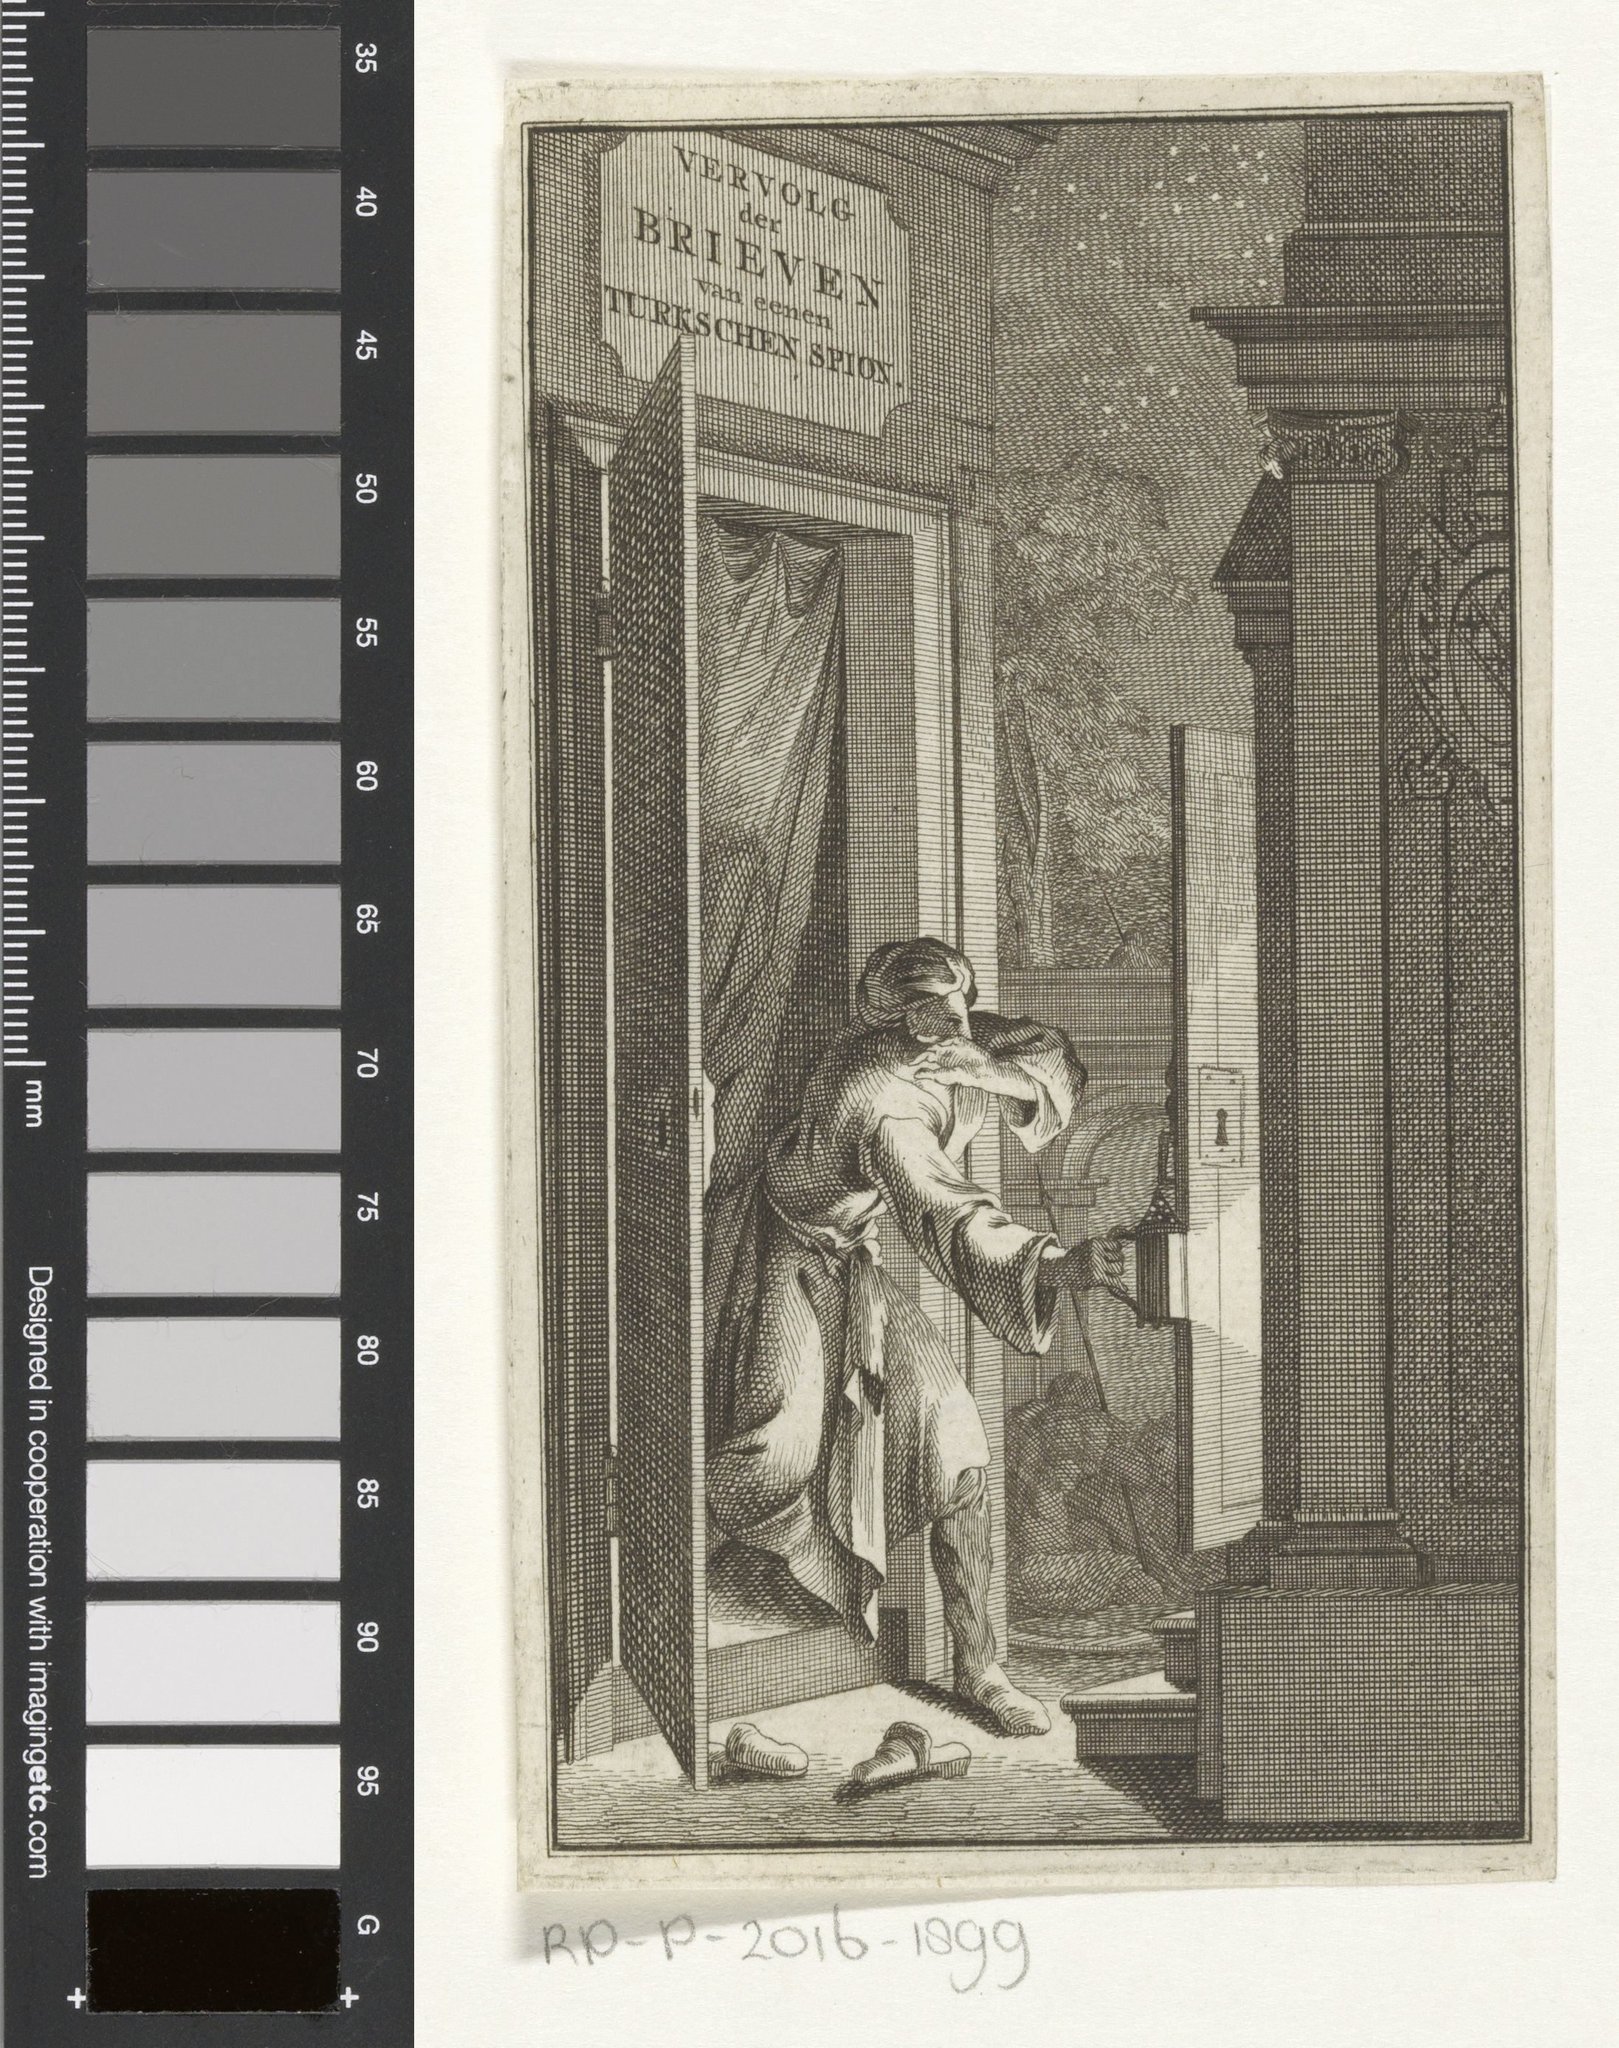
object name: print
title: Turkse spion betreedt gebouw in de nacht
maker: Anonymous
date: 1700-1899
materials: paper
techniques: etching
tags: asiatic races and peoples: turks, (military) espionage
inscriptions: collector's mark: Lugt 2228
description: Een Turkse man met tulband verlaat een gebouw en opent de deur van een tweede gebouw. Zijn linkerhand houdt hij voor zijn gezicht, in zijn rechterhand houdt hij een lantaarn. In de achtergrond zitten figuren in een tuin.